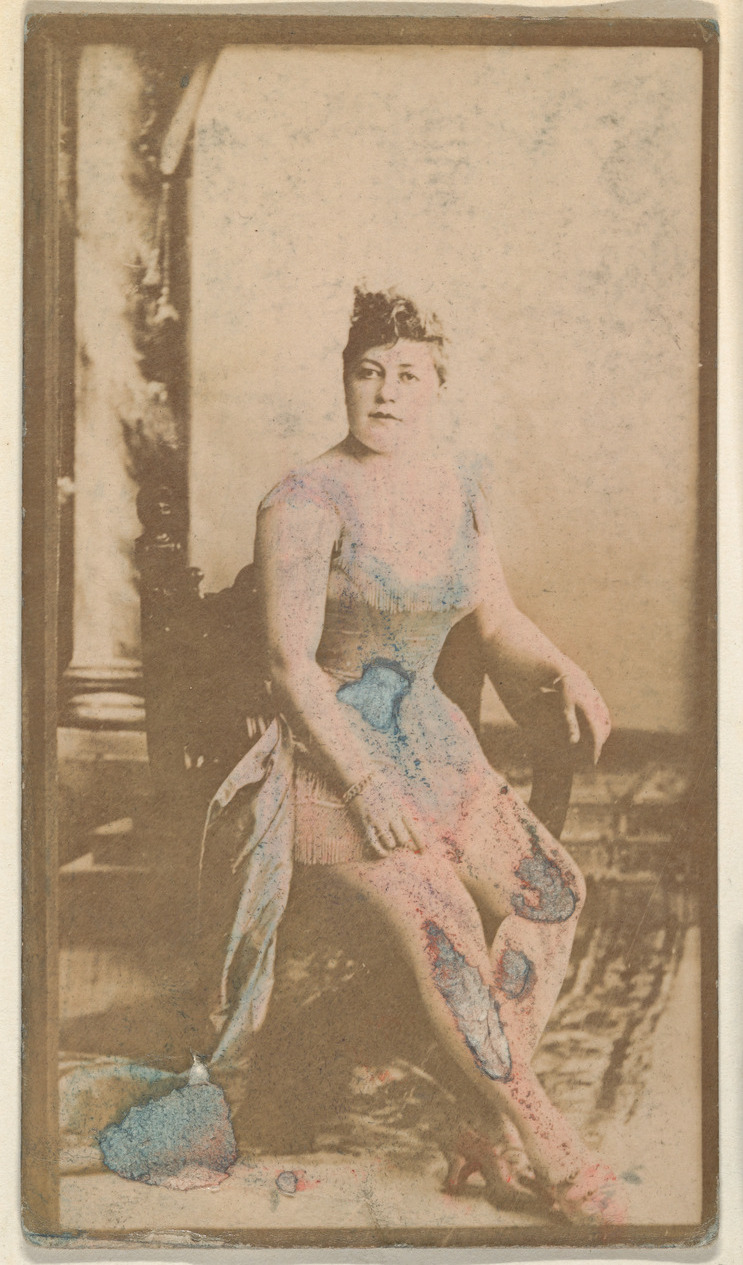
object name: photograph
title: Seated actress blue hand-colored gown, from the Actresses series (N668)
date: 1888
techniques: albumen silver print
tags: portraits,women,actresses